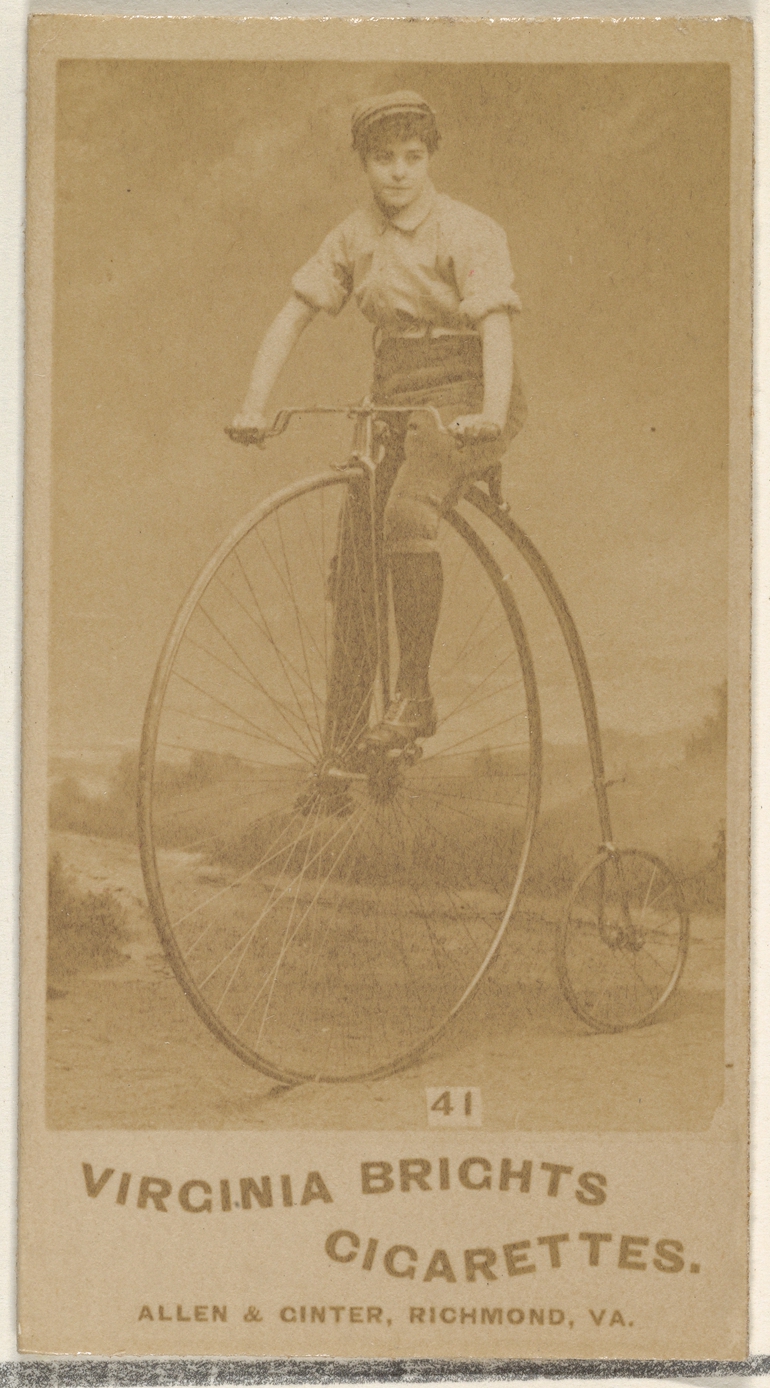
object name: photograph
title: Card 41, from the Girl Cyclists series (N49) for Virginia Brights Cigarettes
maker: allen & ginter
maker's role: publisher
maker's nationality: american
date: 1887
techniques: albumen silver print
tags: girls,portraits,bicycles